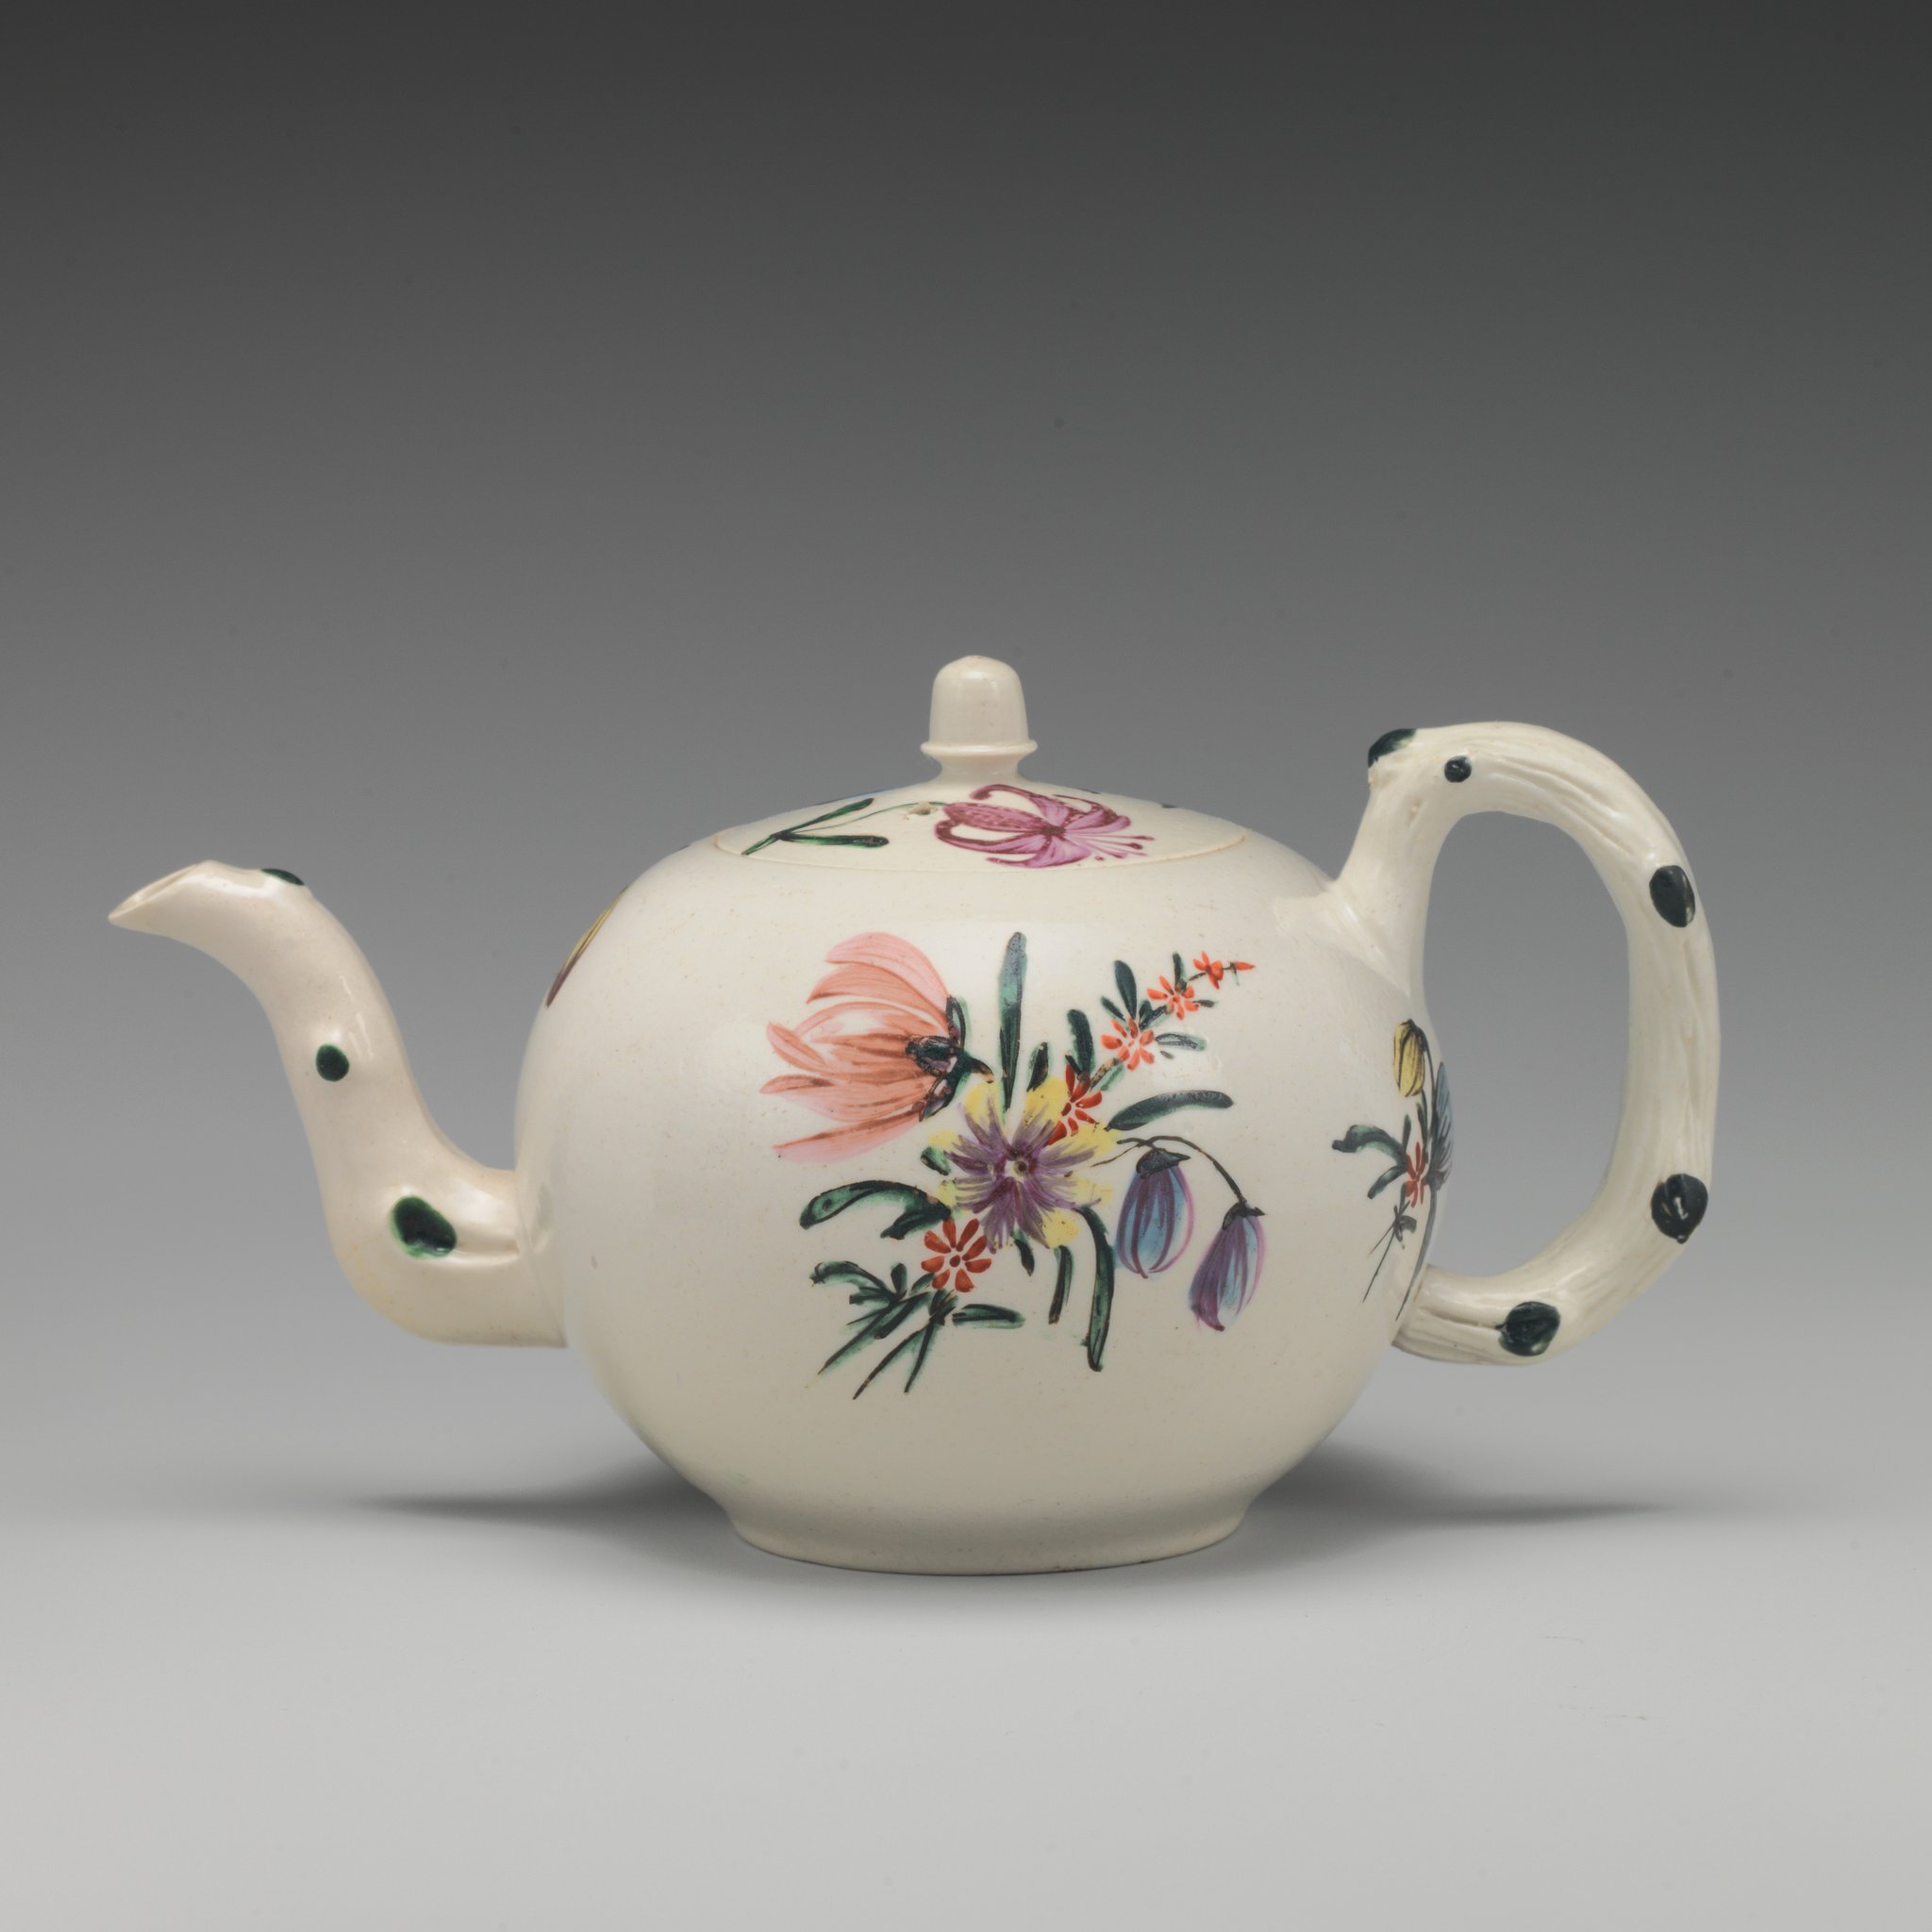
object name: teapot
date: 1755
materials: enamel, stoneware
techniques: salt glaze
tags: flowers,leaves